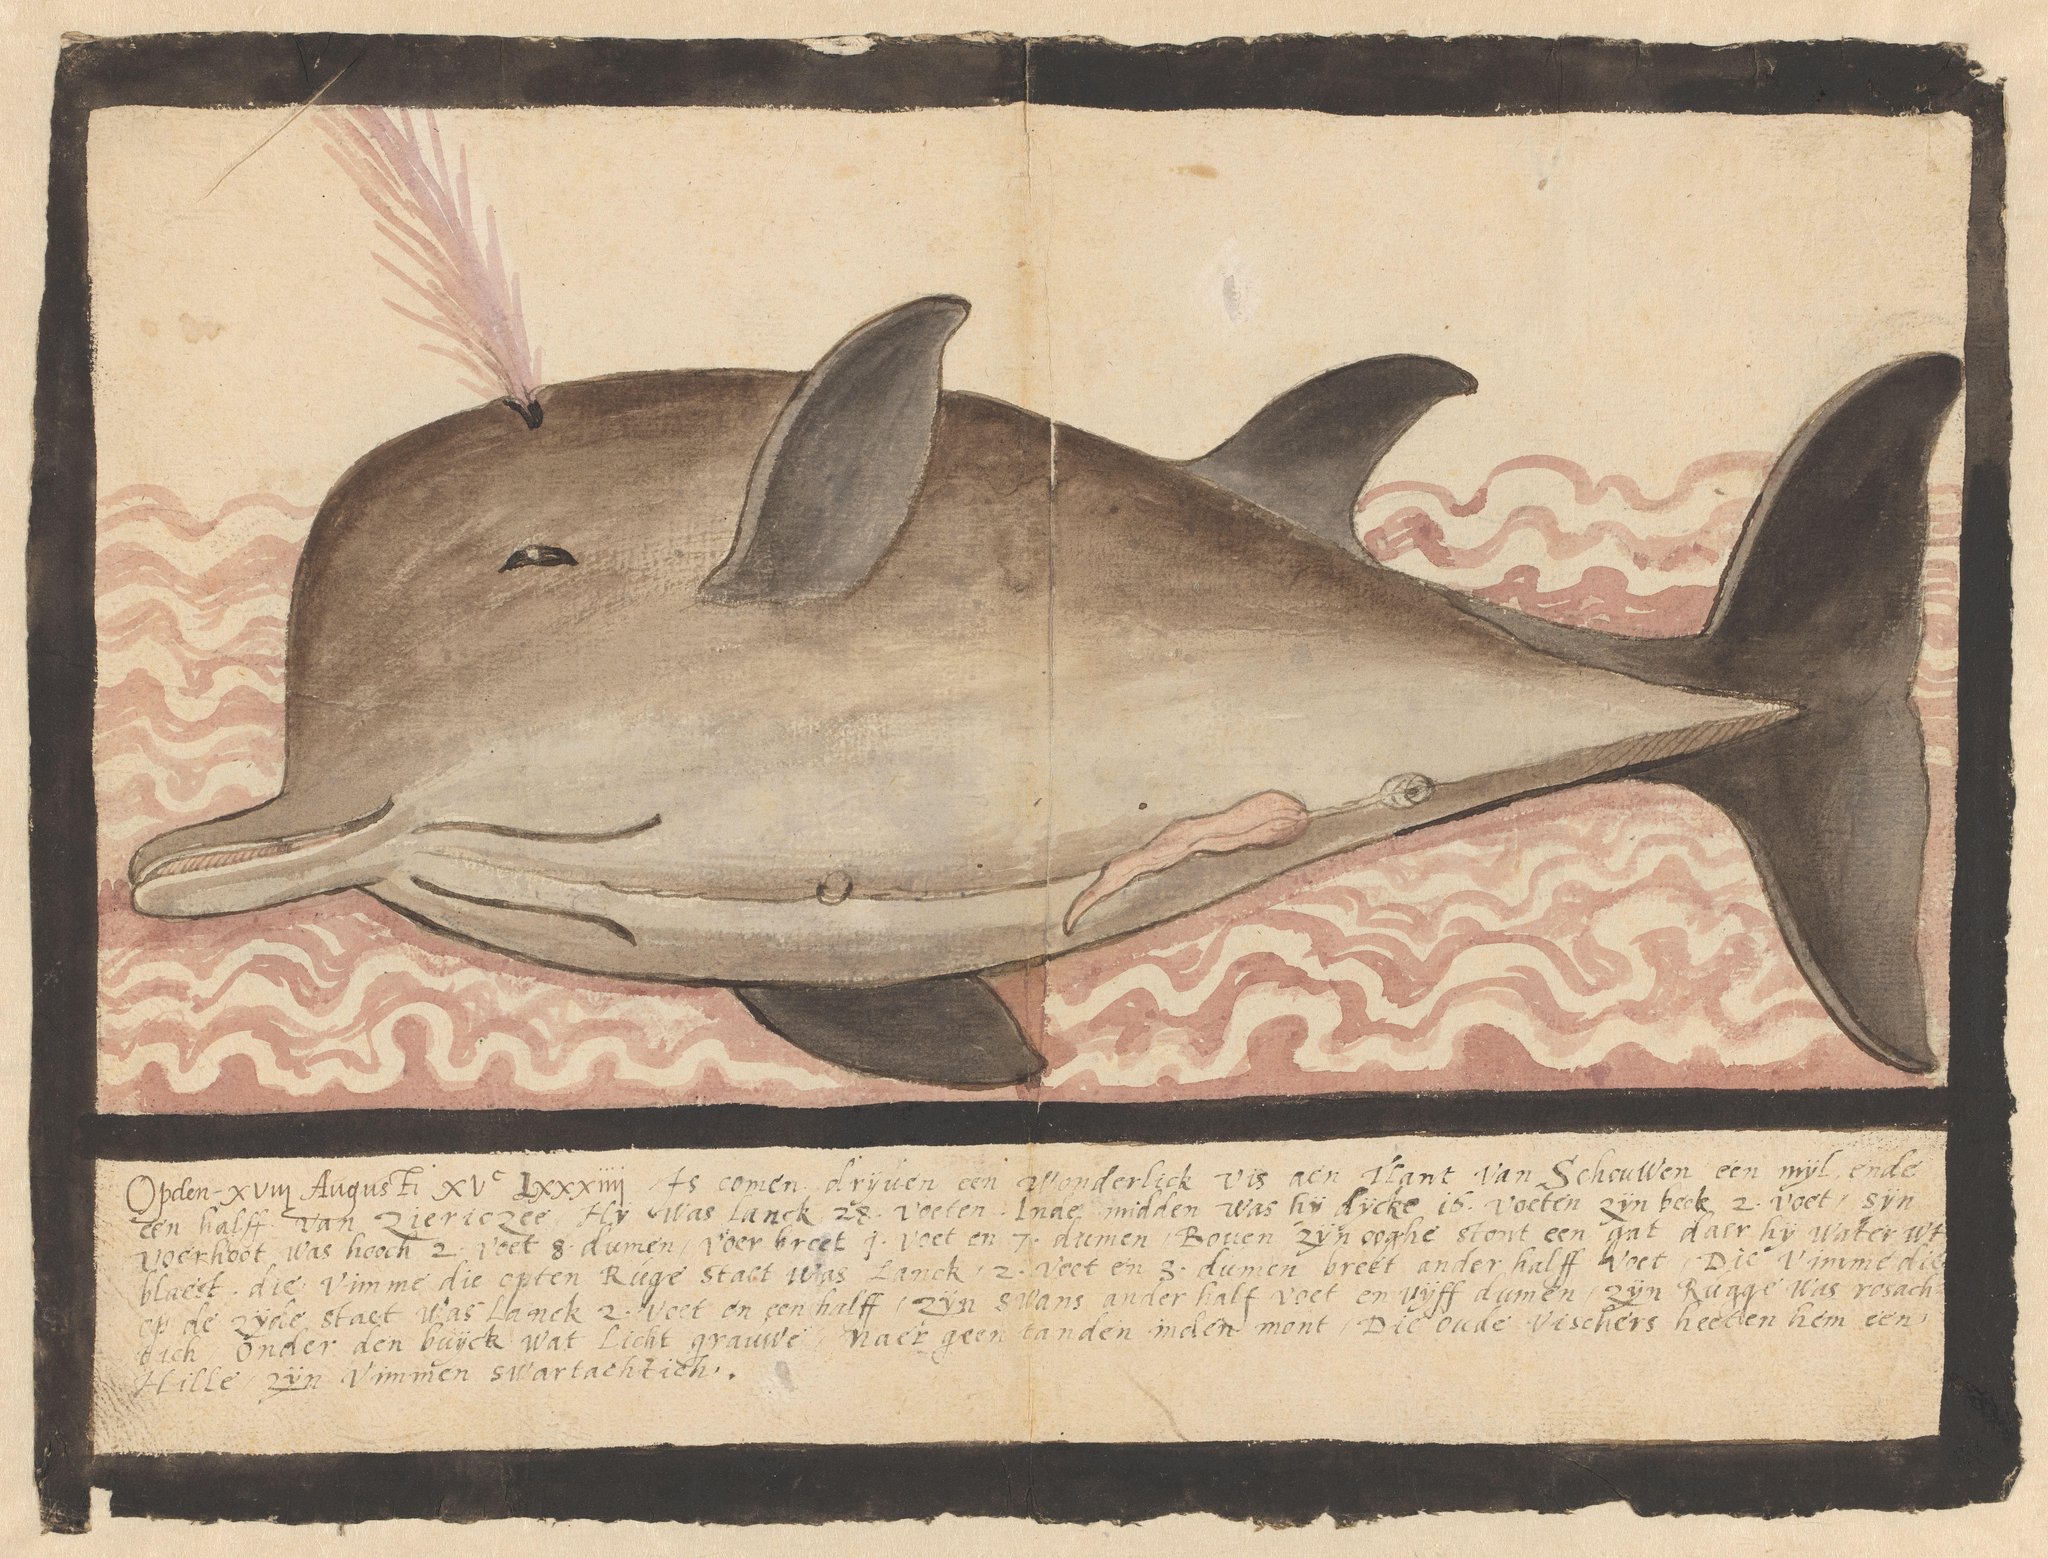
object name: drawing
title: Buttlenose whale (Hyperoodon rostratus)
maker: adriaen coenen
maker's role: draughtsman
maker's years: 1514-1587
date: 1584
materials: graphite, ink, paper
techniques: brush, pen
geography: zeeland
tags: swimming mammals: whale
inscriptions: inscription: ‘Opden – xviij Augusti xvcLxxxiiij is comen drijven een wonderlick vis aen t’lant van Schouwen een mijl, ende / een halff van ziericzee Hy was lanck 28 . voeten . In de midden was hij dijcke 16 . voeten zijn beck 2 . voet/ sijn / voerhoof was hooch 2 . voet 8 . dumen/ voer breet 1. voet en 7. Dumen/ Bouen zijn ooghe stont een gat daer hij water wt / blaest . die vimme die opten Ruge staet was lanck 2 . voet en 3 . dumen breet ander half voet/ Die vimme die / op de zijde staet was lanck 2 . voet en een half/ zijn swans ander half voet en vijff dumen/ zijn Rugge was rosach / tich onder den buijck wat licht Grauwe/ maer geen tanden in den mont , die oude vischers heeten hem een Hille/ zijn vinnen swartachtich.’